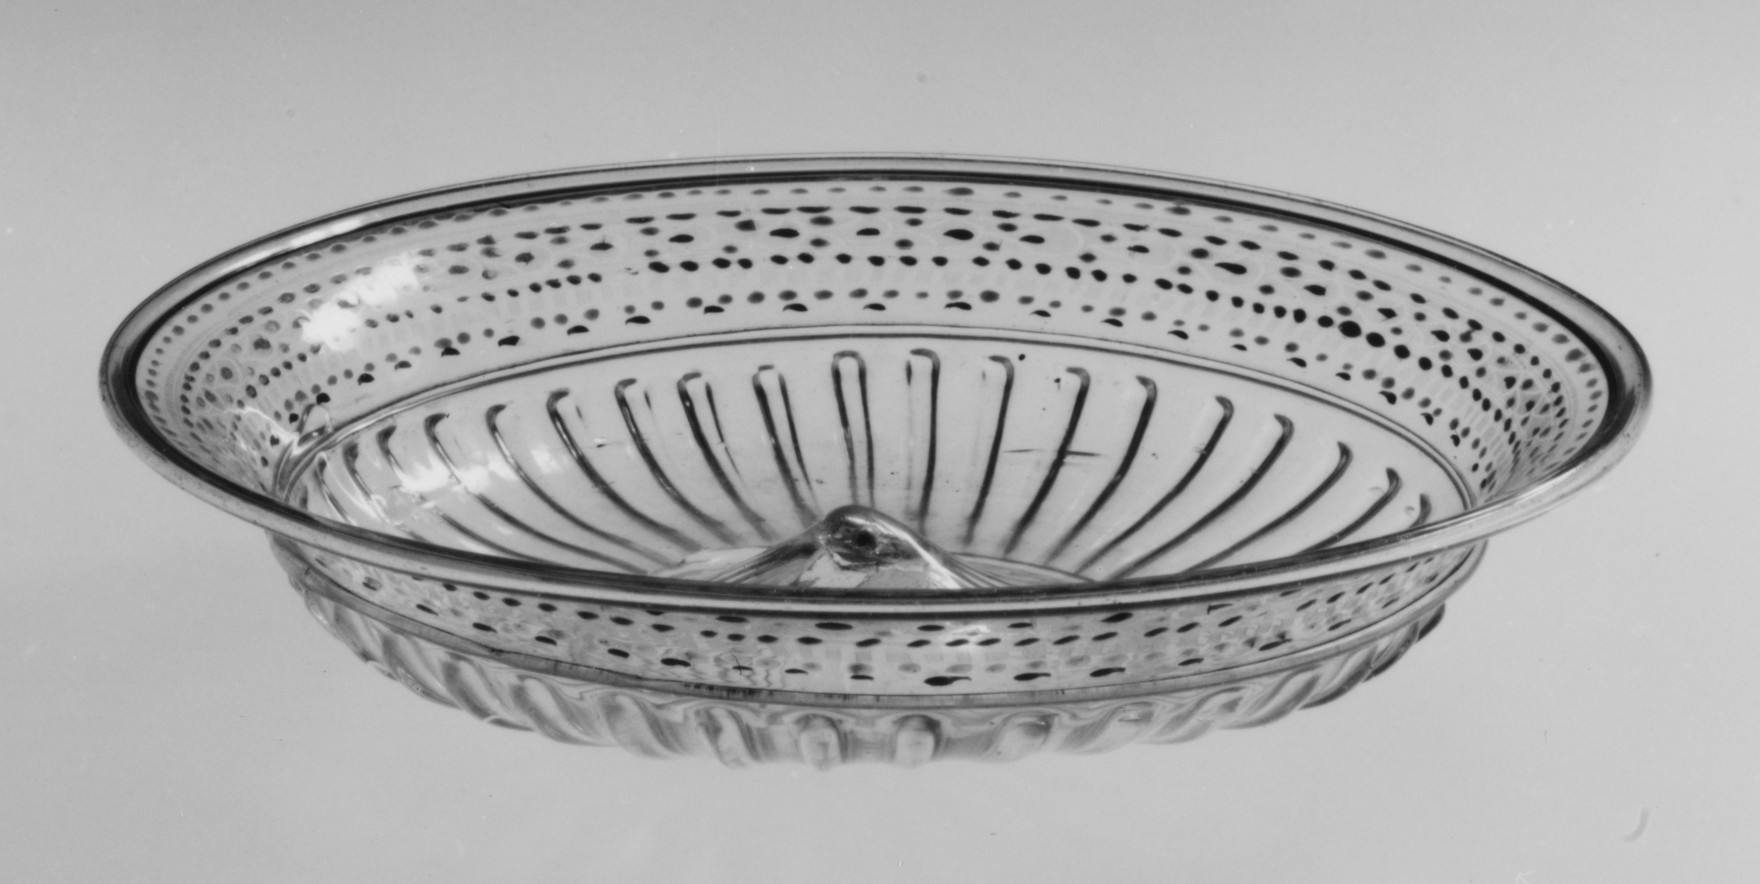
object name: bowl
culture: italian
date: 1500-1525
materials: gilt, glass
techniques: glassblowing, enamel, molding